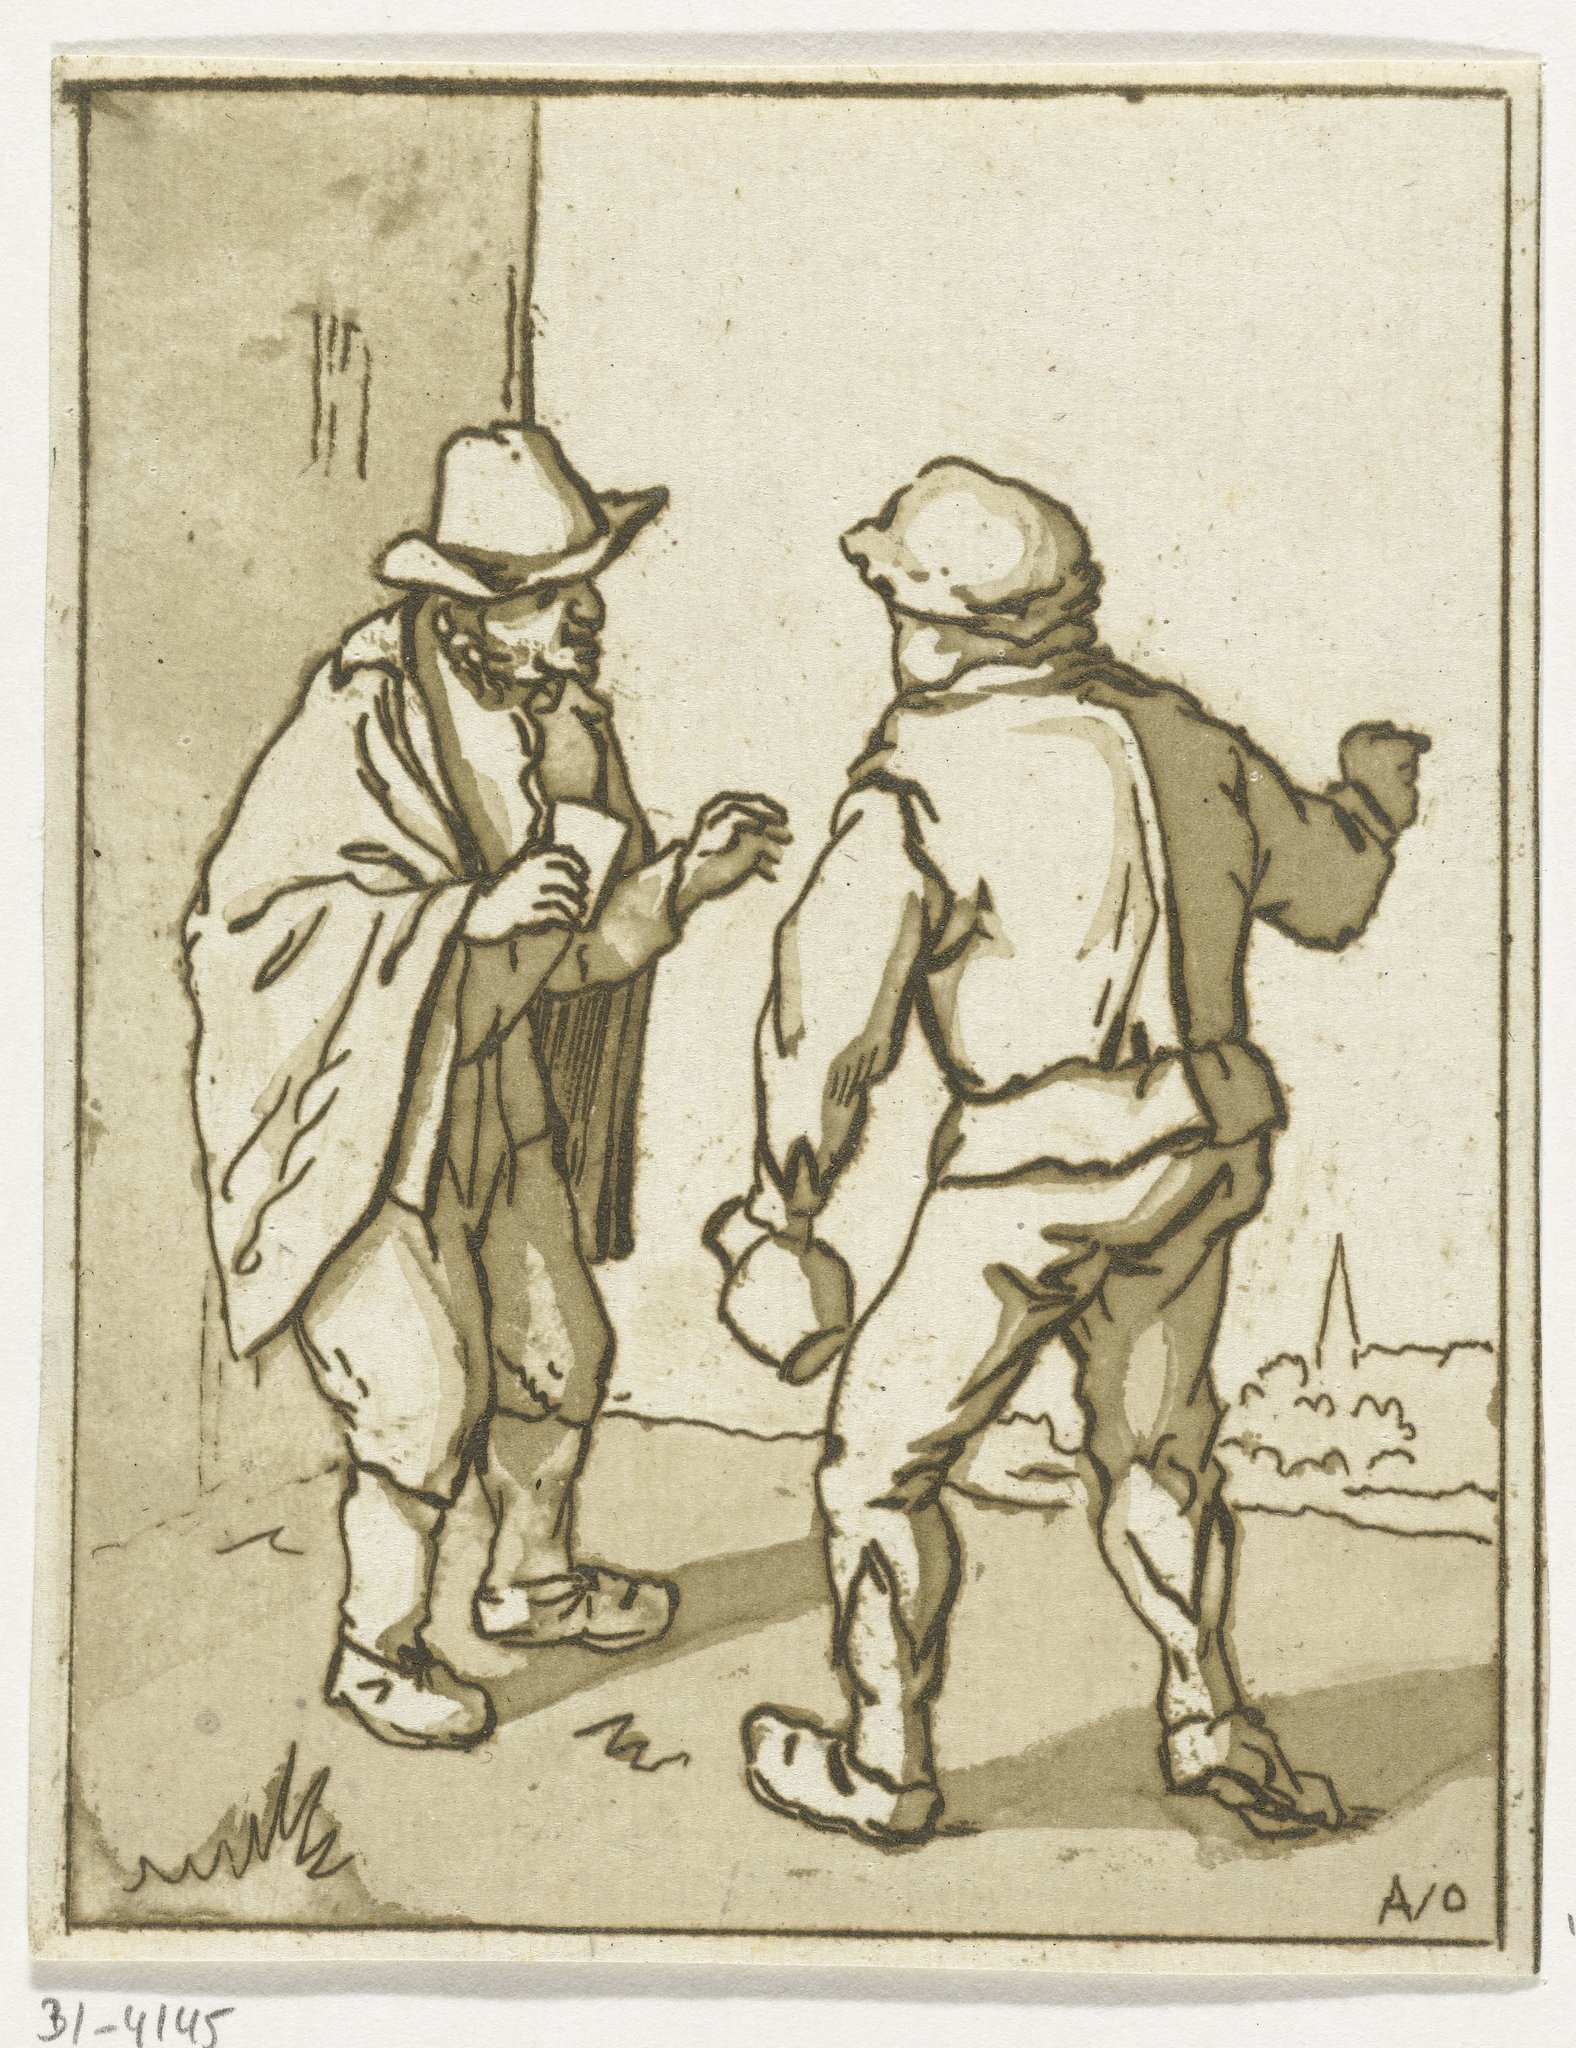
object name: print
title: Twee staande mannen in gesprek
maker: anthonie van den bos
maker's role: draughtsman, print maker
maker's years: 1763-1838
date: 1778-1838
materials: paper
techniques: aquatint, etching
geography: netherlands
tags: meeting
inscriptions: collector's mark: Lugt 2228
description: Twee mannen ontmoeten elkaar op de weg. De een houdt een kruik in zijn hand. Hij wijst de ander de weg.